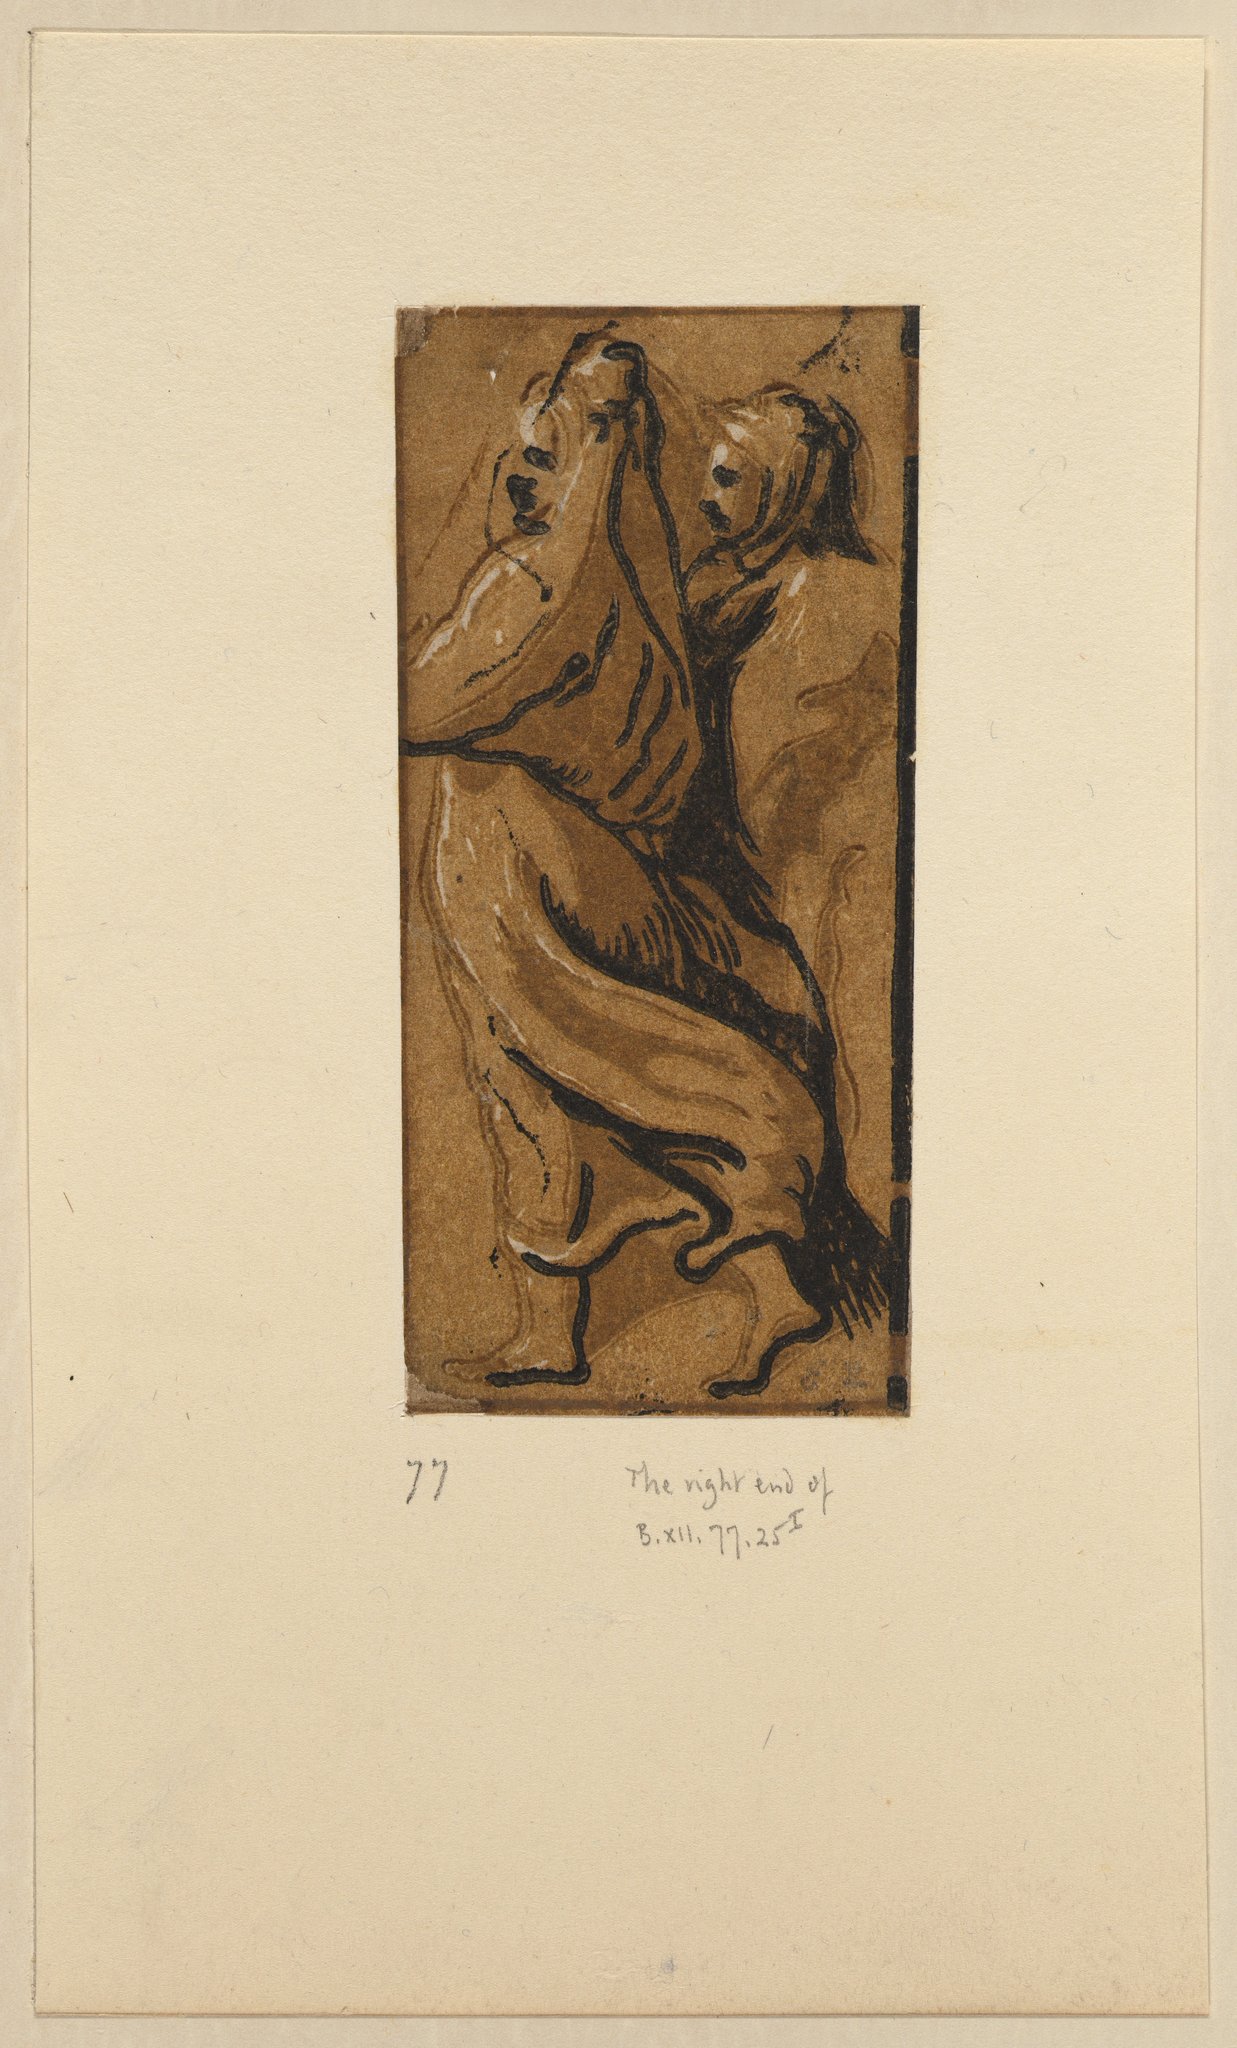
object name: print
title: Right hand section of St Peter preaching to the apostles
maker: niccolò vicentino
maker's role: artist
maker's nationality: italian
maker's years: 1510-1550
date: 1540-1550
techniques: woodcut